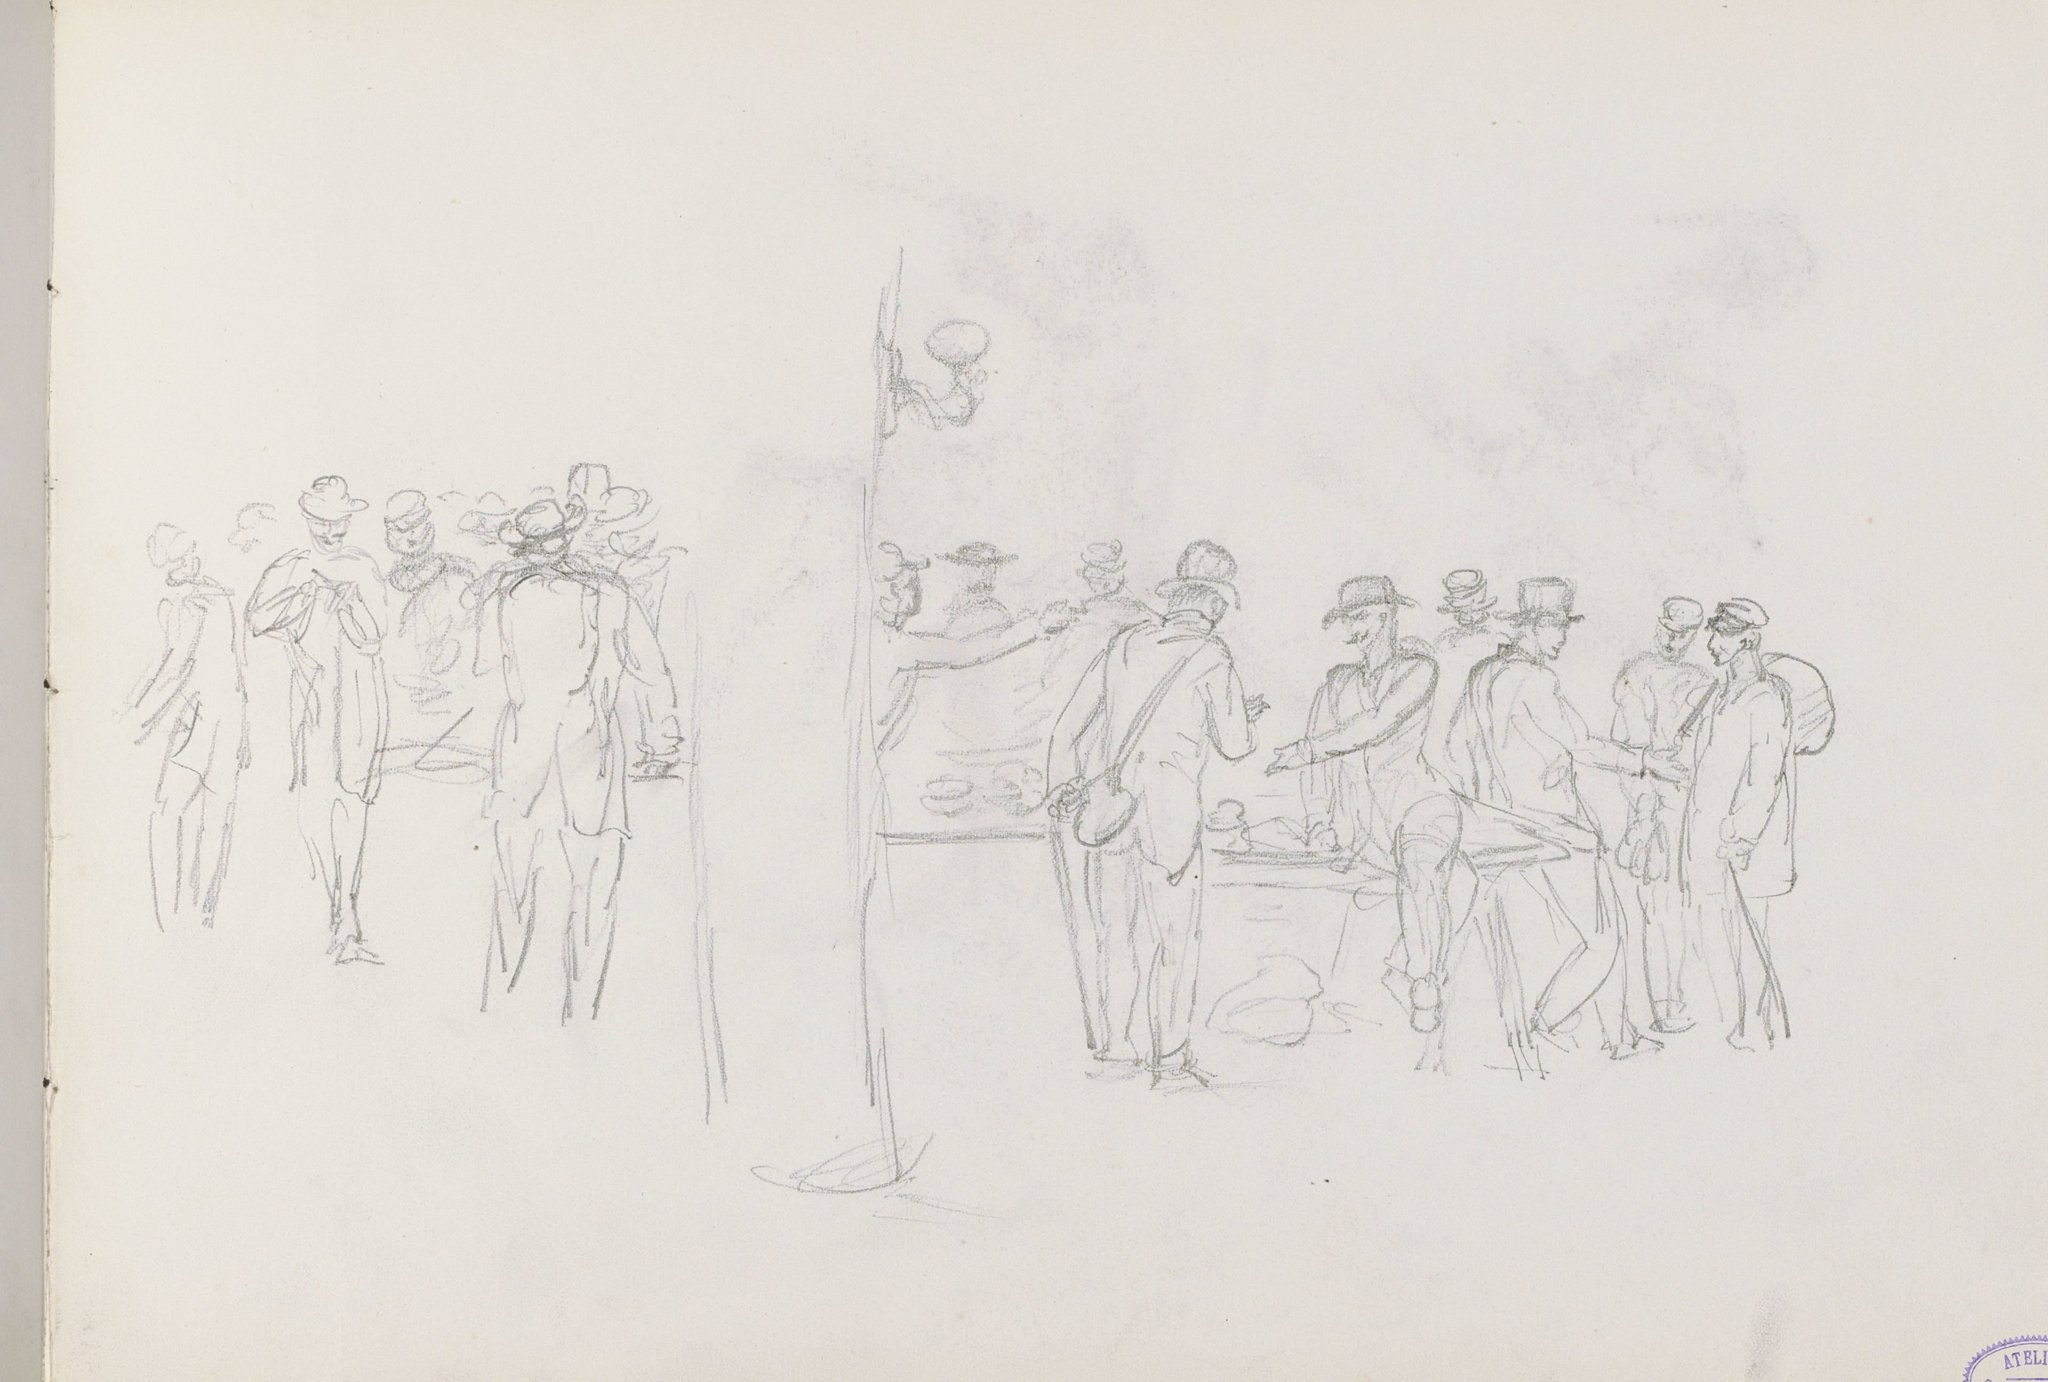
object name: sketchbook leaf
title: Mannen op en rond een gedekte tafel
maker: george hendrik breitner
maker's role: draughtsman, painter, print maker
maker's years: 1857-1923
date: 1873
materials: paper, pencil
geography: rotterdam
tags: adult man, laid table: table-ware, table-decoration, etc.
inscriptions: workshop stamp: Lugt 291d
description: Blad 28 recto uit een schetsboek met 25 bladen.